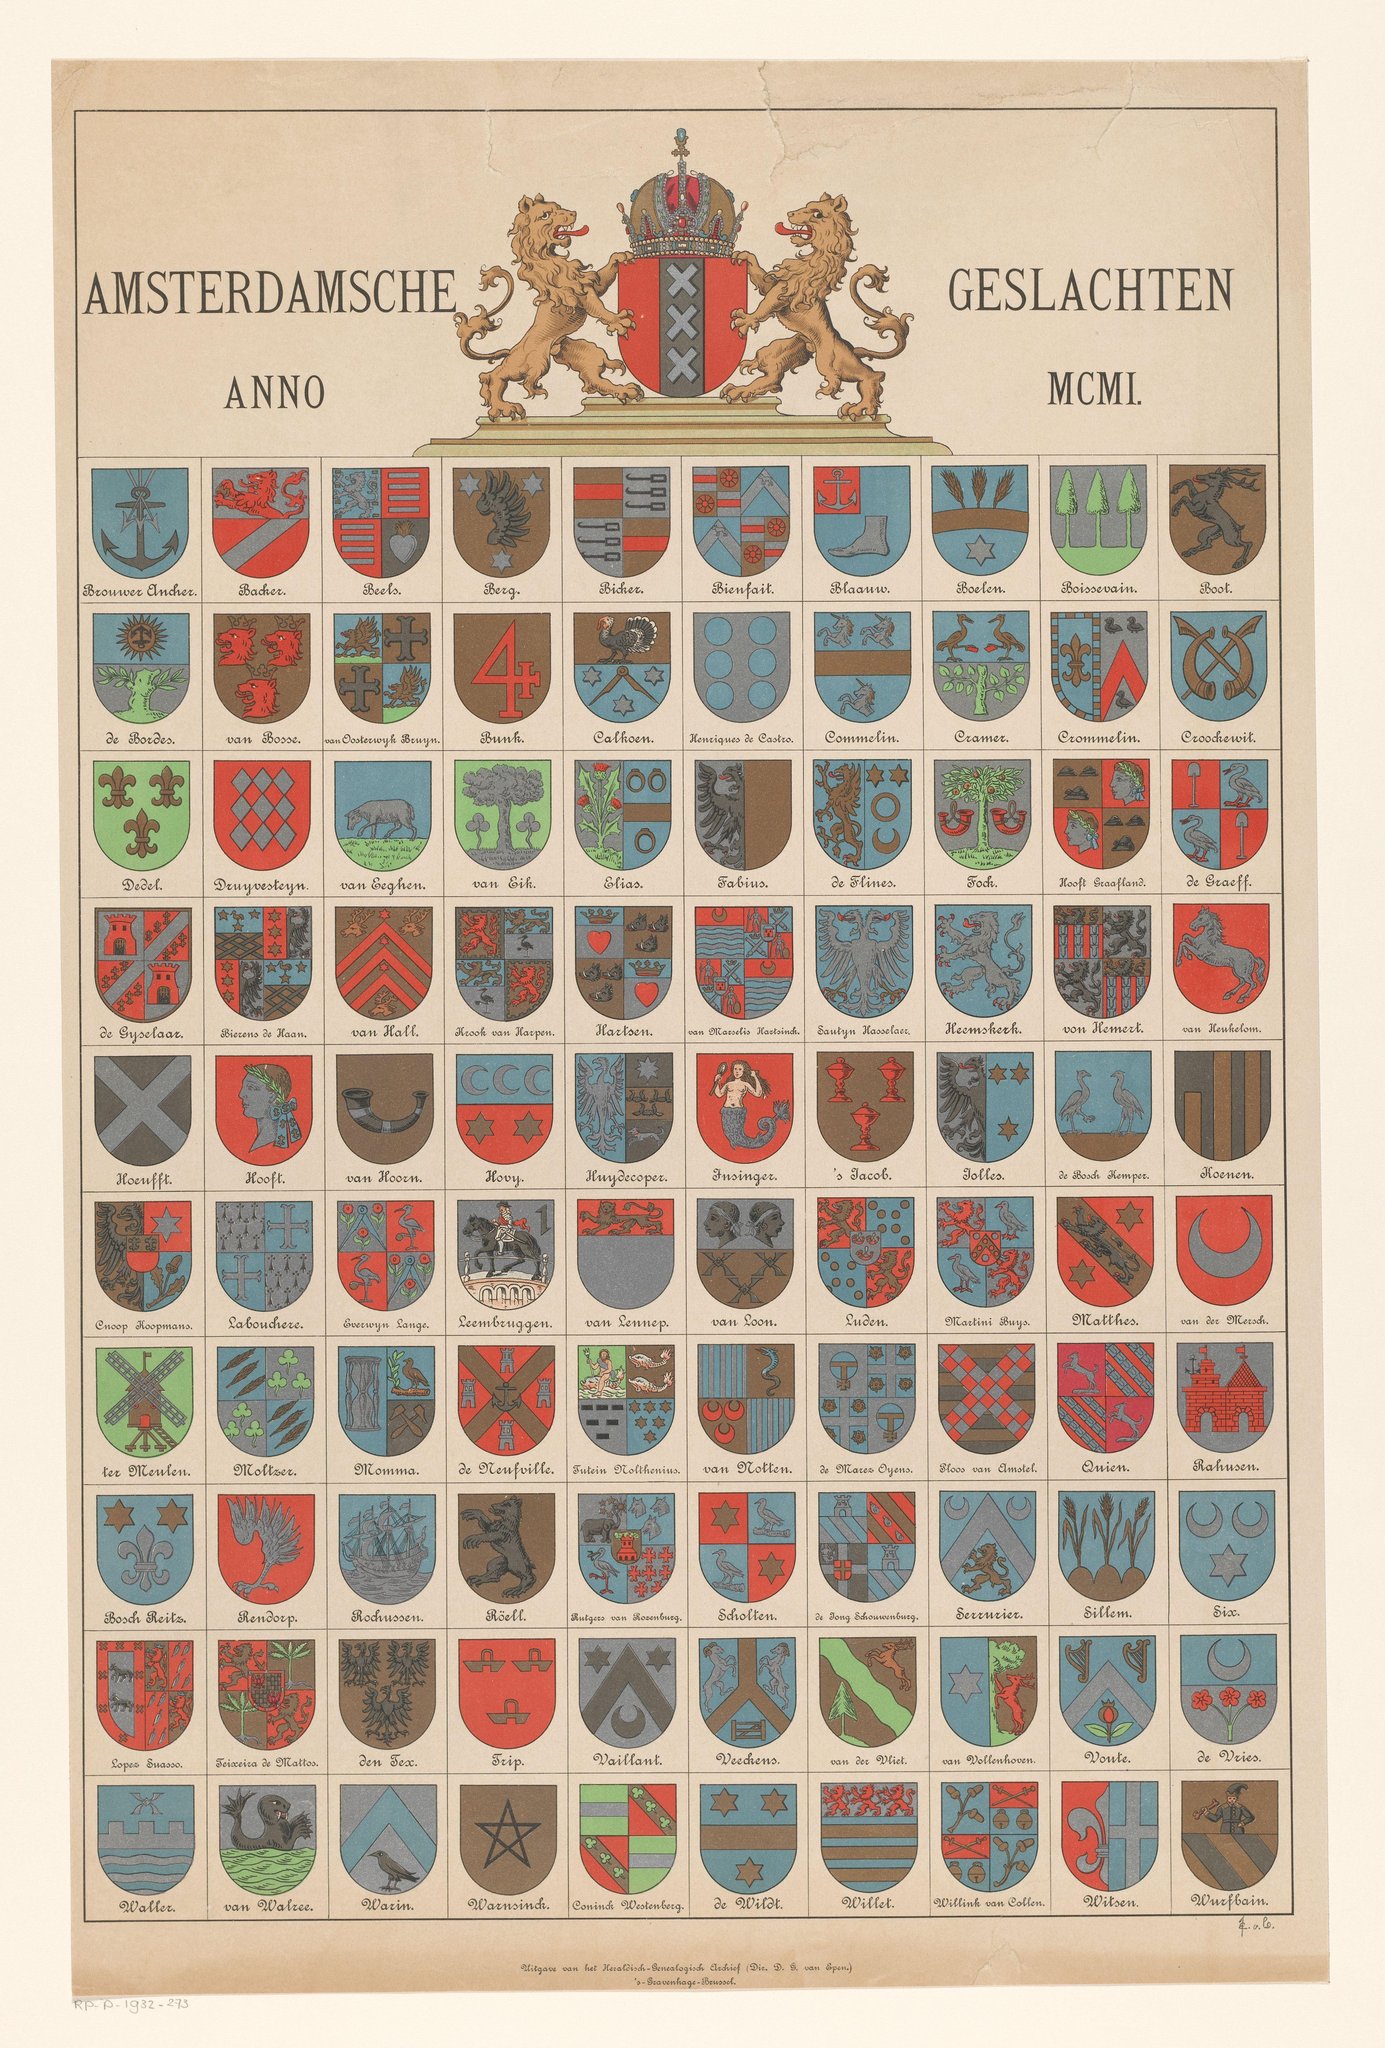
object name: print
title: Amsterdamsche Geslachten. Anno MCMI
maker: johannes evert van leeuwen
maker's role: painter, print maker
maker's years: 1855-1931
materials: paper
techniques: chromolithography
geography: netherlands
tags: armorial bearing, heraldry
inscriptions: collector's mark: Lugt 2228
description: Wapenbord met het wapen van Amsterdam en honderd familiewapens.